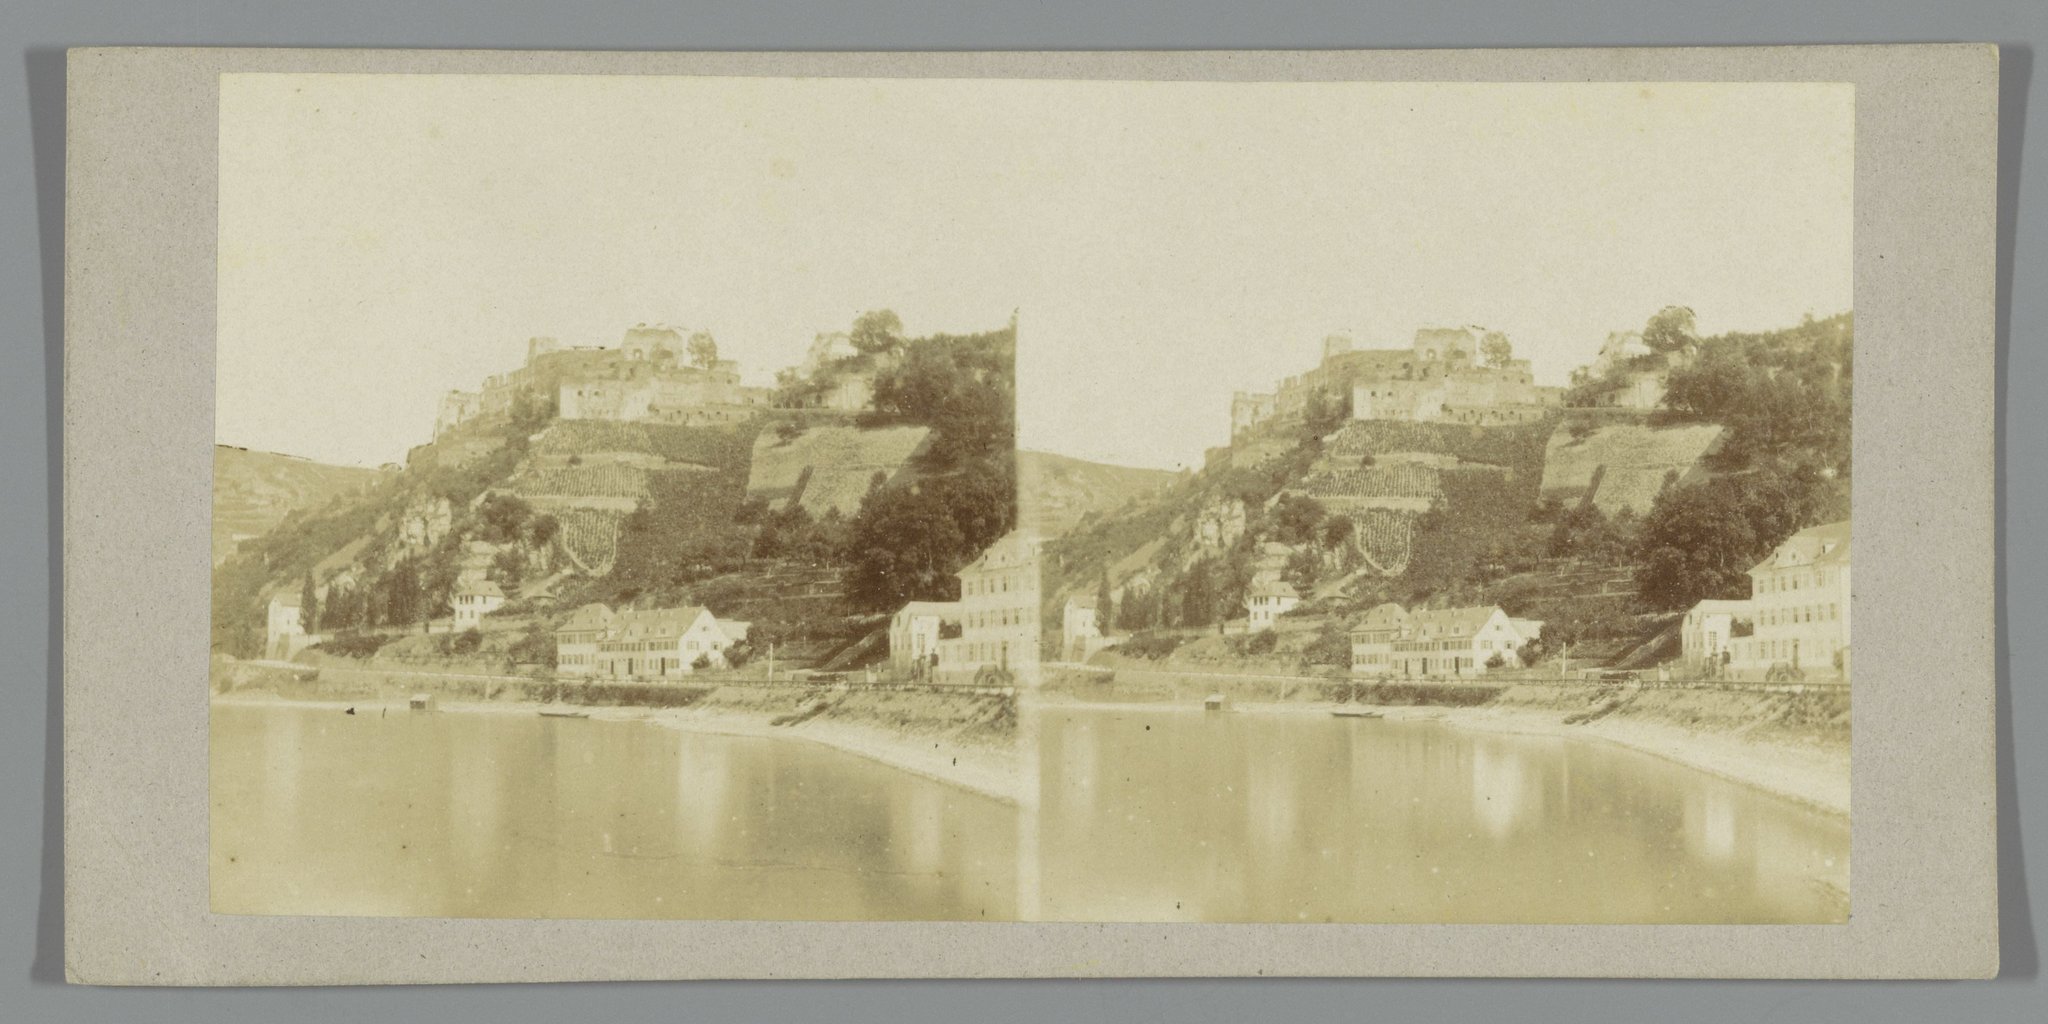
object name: stereograph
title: Gezicht op Sankt Goar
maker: Anonymous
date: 1855-1870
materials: cardboard, photographic support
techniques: albumen print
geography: sankt goar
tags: city-view in general; 'veduta'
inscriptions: inscription: ‘Forteresse Rheinfels a St Goar’